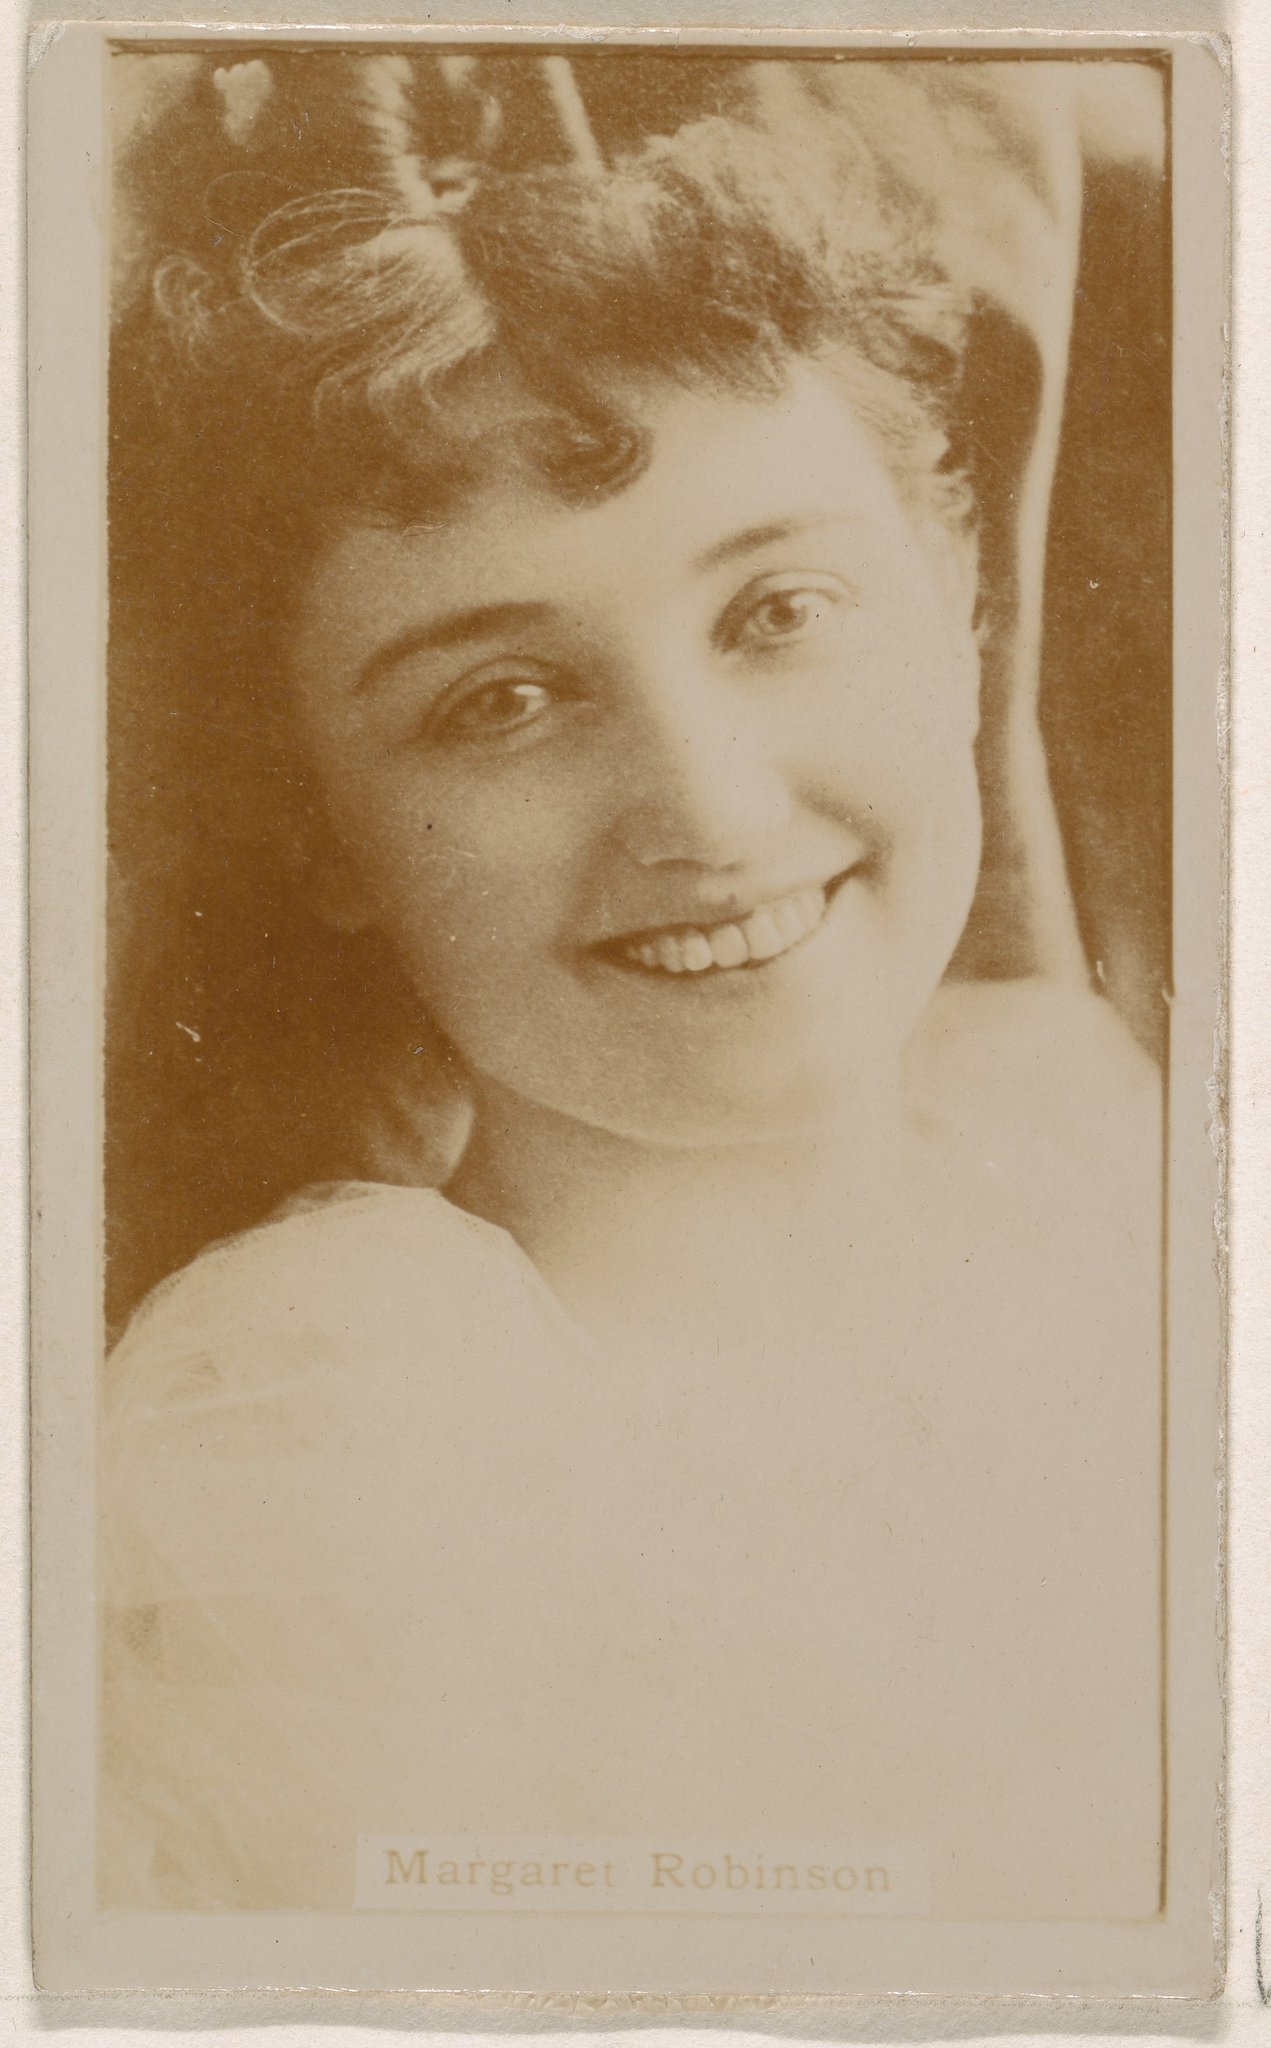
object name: photograph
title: Margaret Robinson, from the Actresses series (N245) issued by Kinney Brothers to promote Sweet Caporal Cigarettes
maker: kinney brothers tobacco company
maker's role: publisher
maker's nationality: american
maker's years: 1869-2011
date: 1890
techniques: albumen silver print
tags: portraits,women,actresses